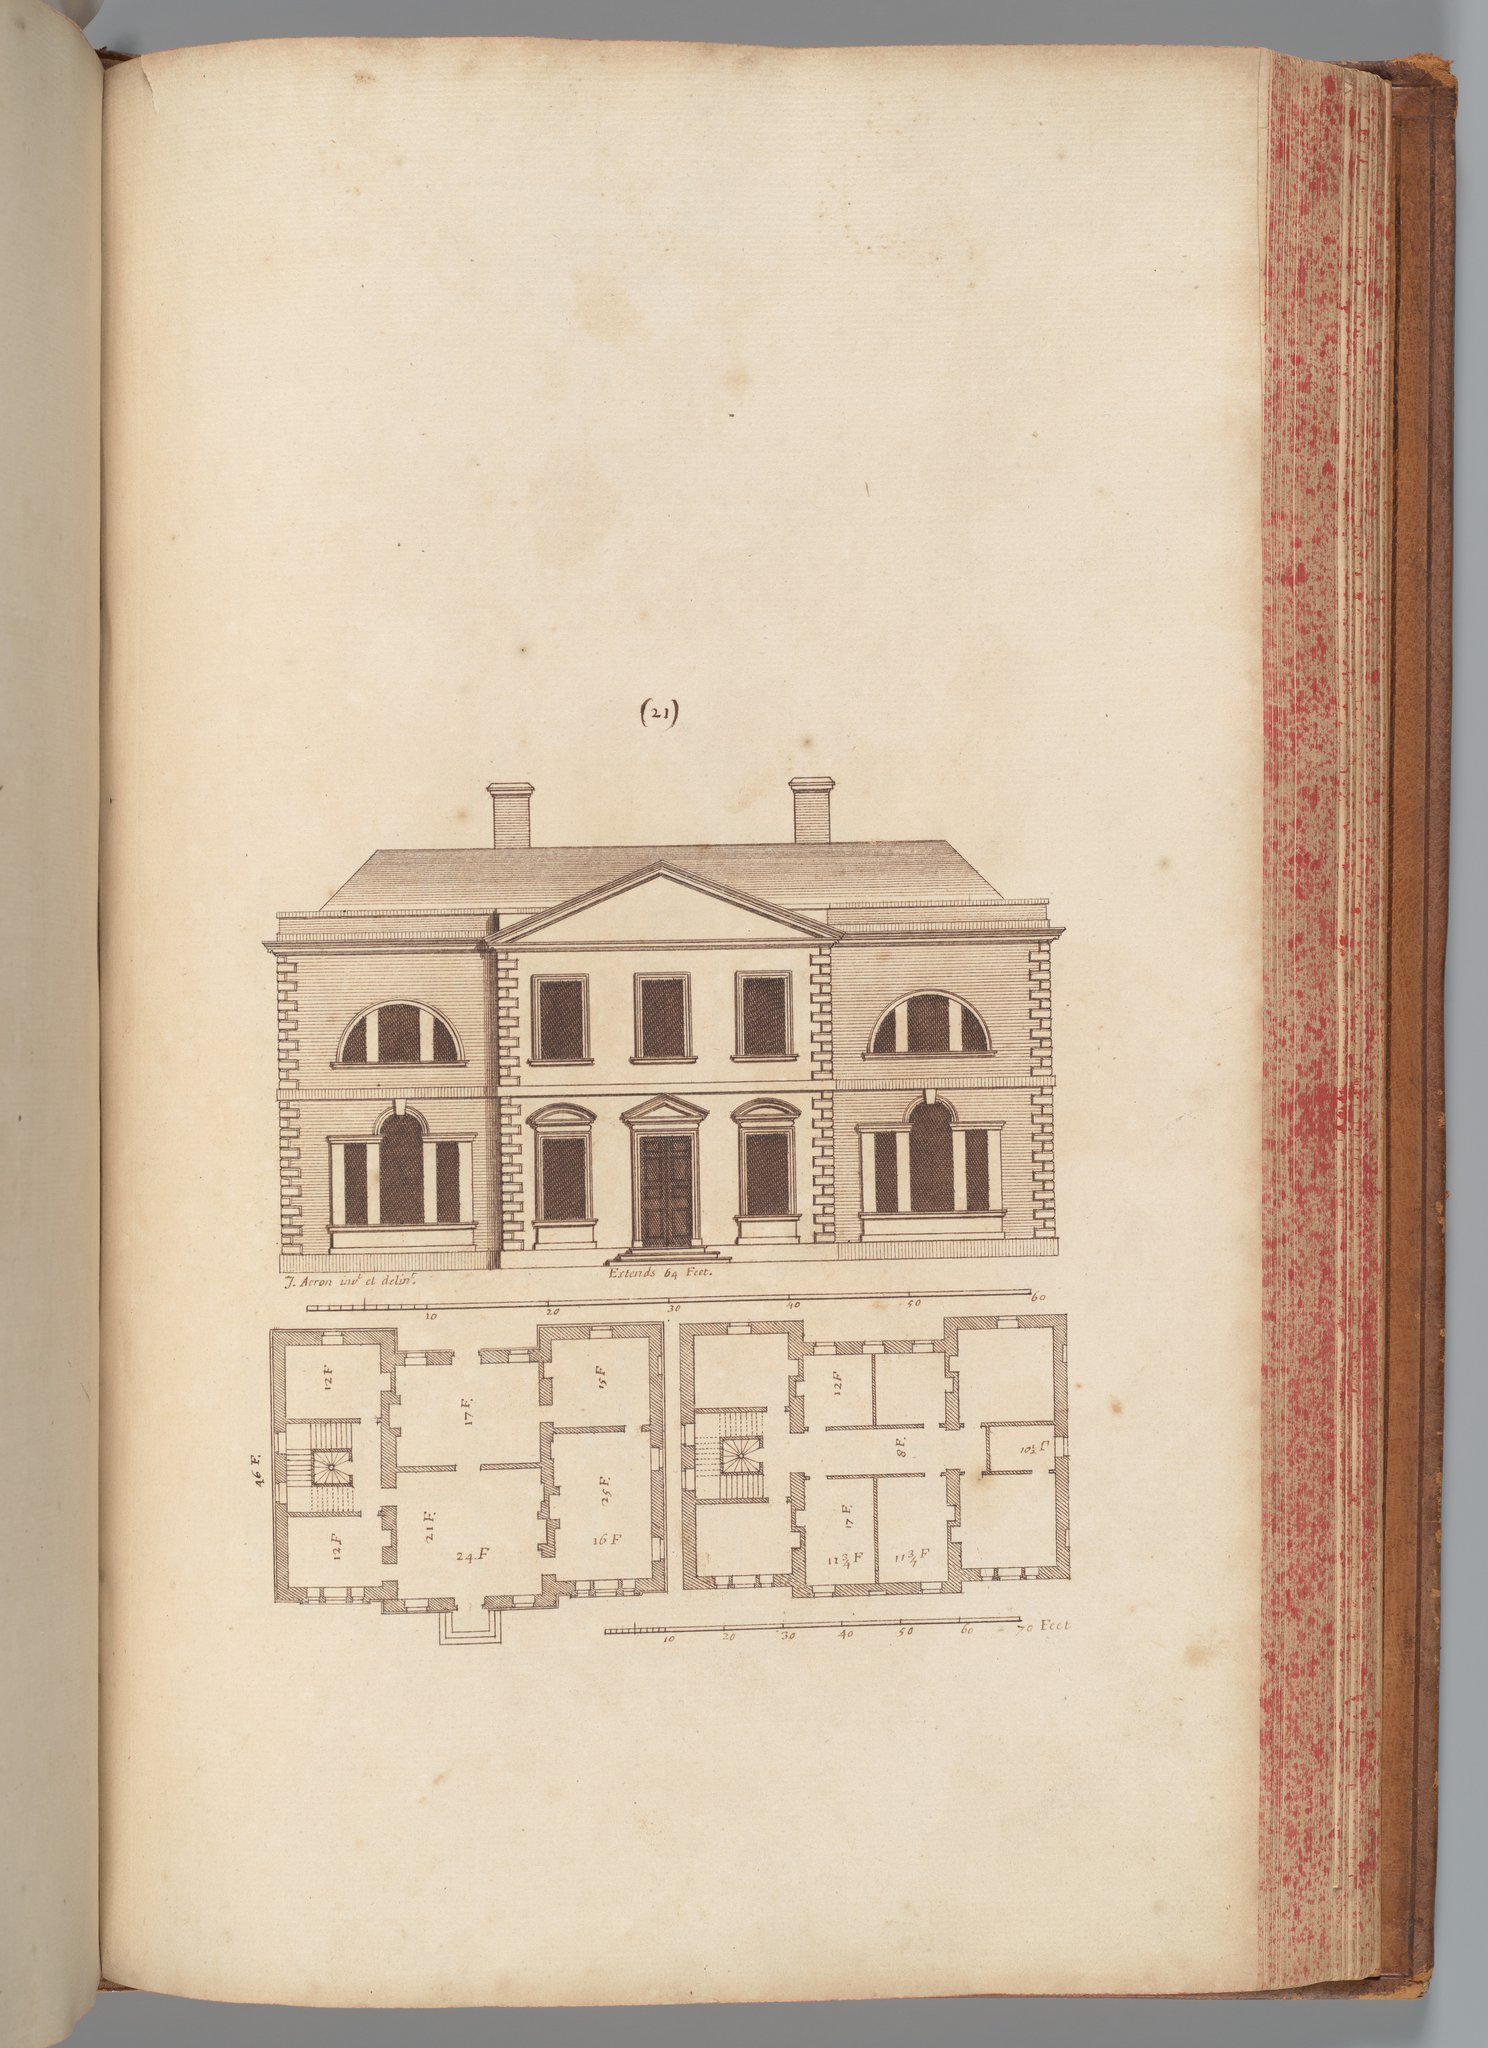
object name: album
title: A General Treatise of Architecture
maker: john aheron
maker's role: author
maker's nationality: irish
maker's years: 1661-1761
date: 1751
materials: ink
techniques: pen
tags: architecture